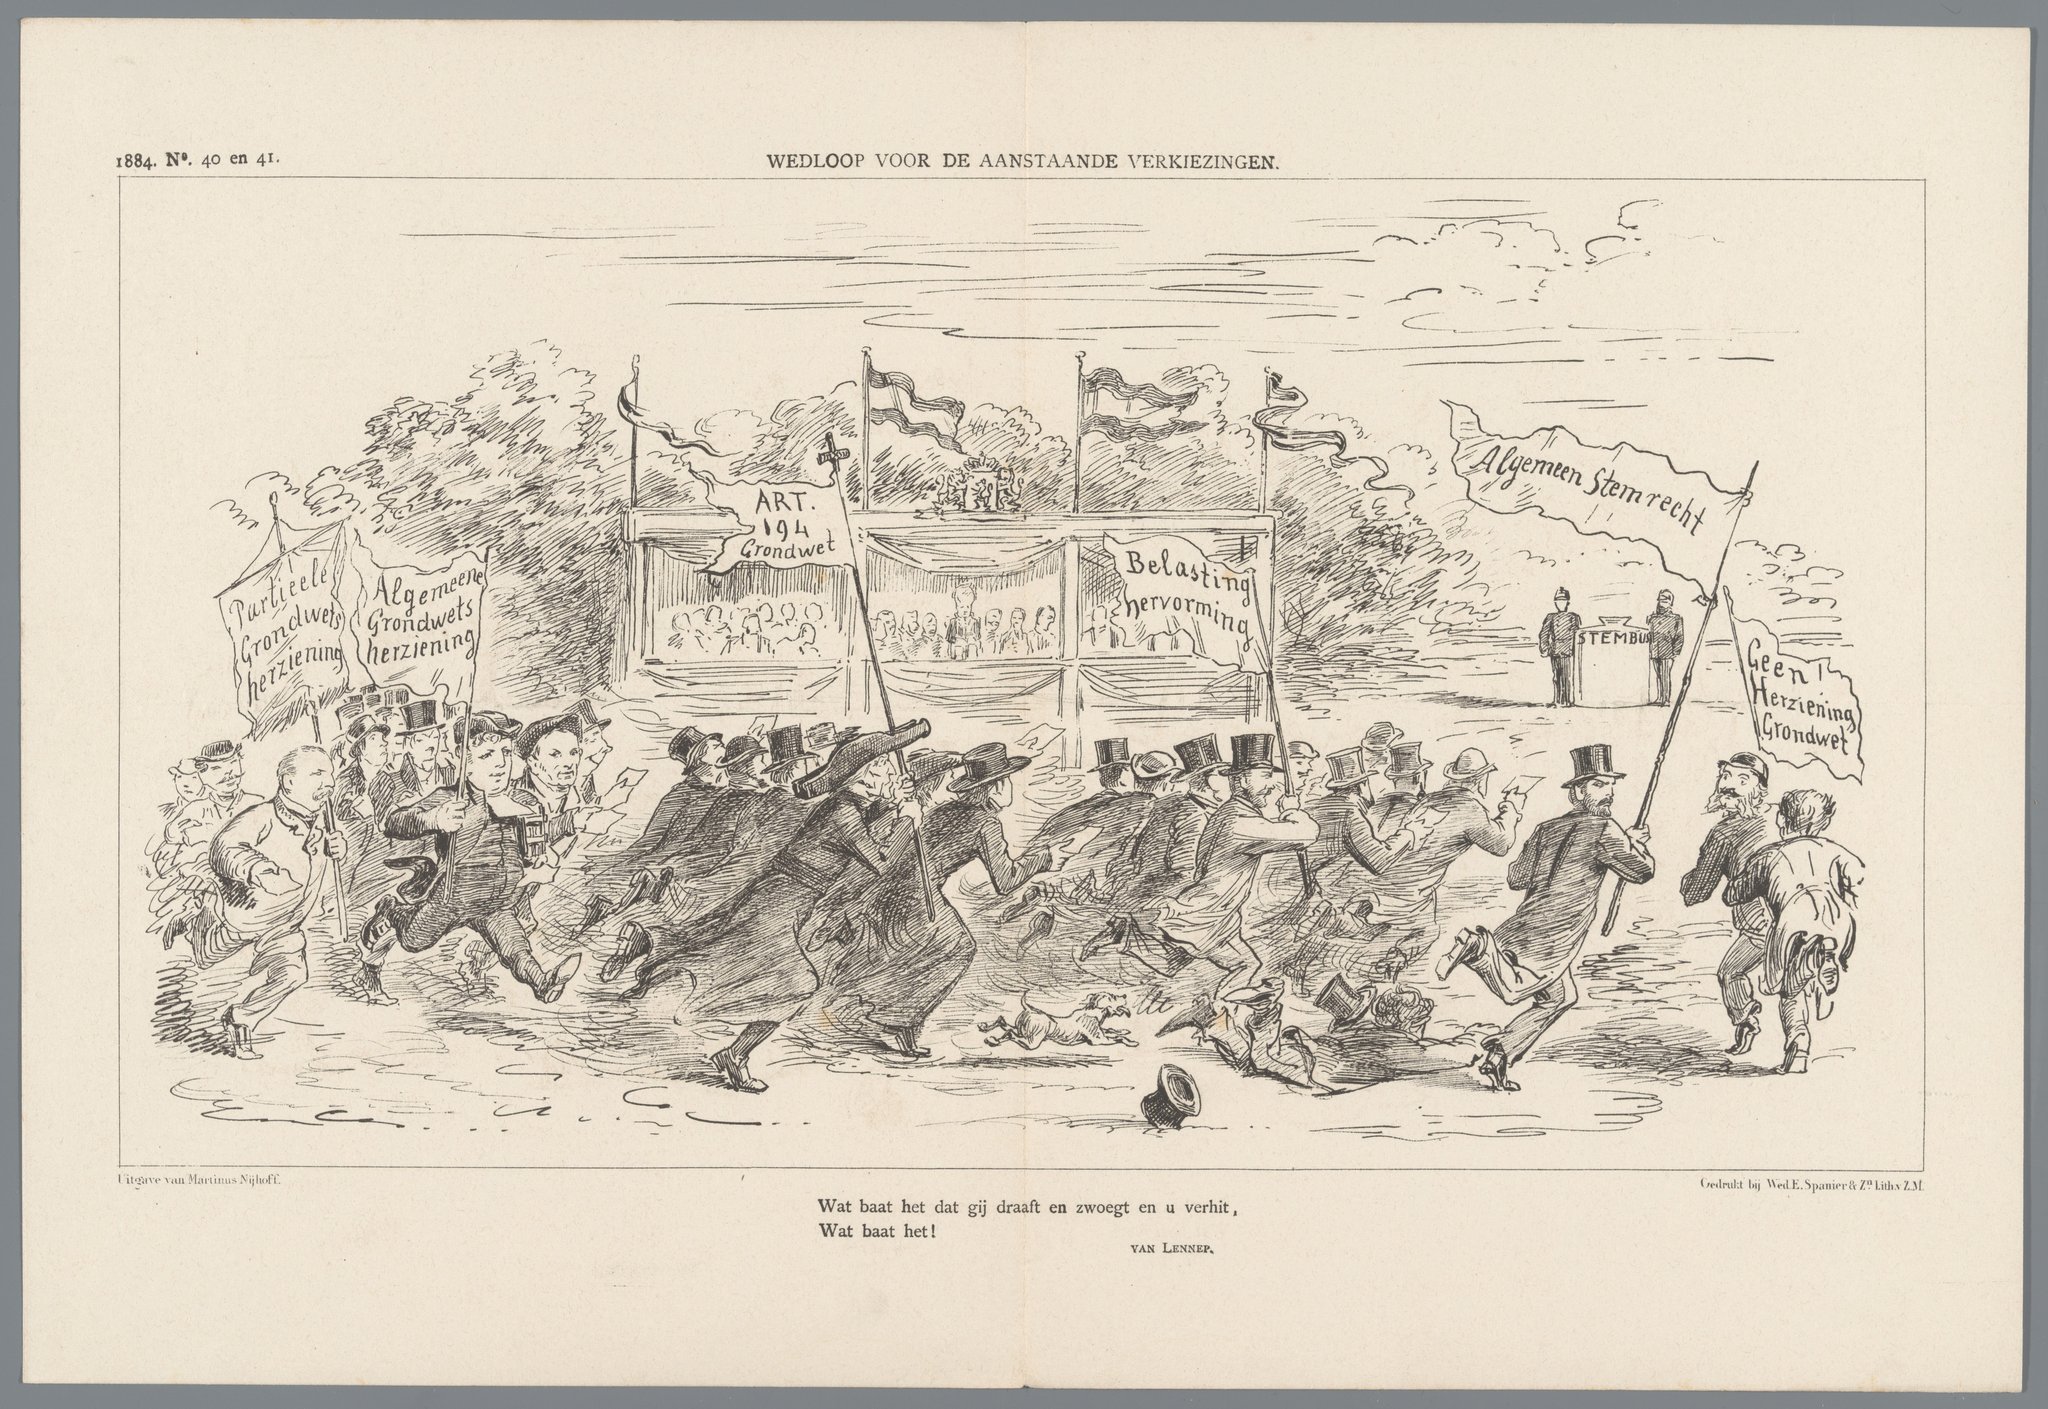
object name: cartoon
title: Wedloop voor de aanstaande verkiezingen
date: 1884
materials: paper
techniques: lithograph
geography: netherlands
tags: tweede kamer der staten-generaal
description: Spotprent over de aanstaande verkiezingen. Wedloop van de politieke partijen. Plaat verschenen bij het weekblad De Nederlandsche Spectator, nr. 40 en 41, 1884.